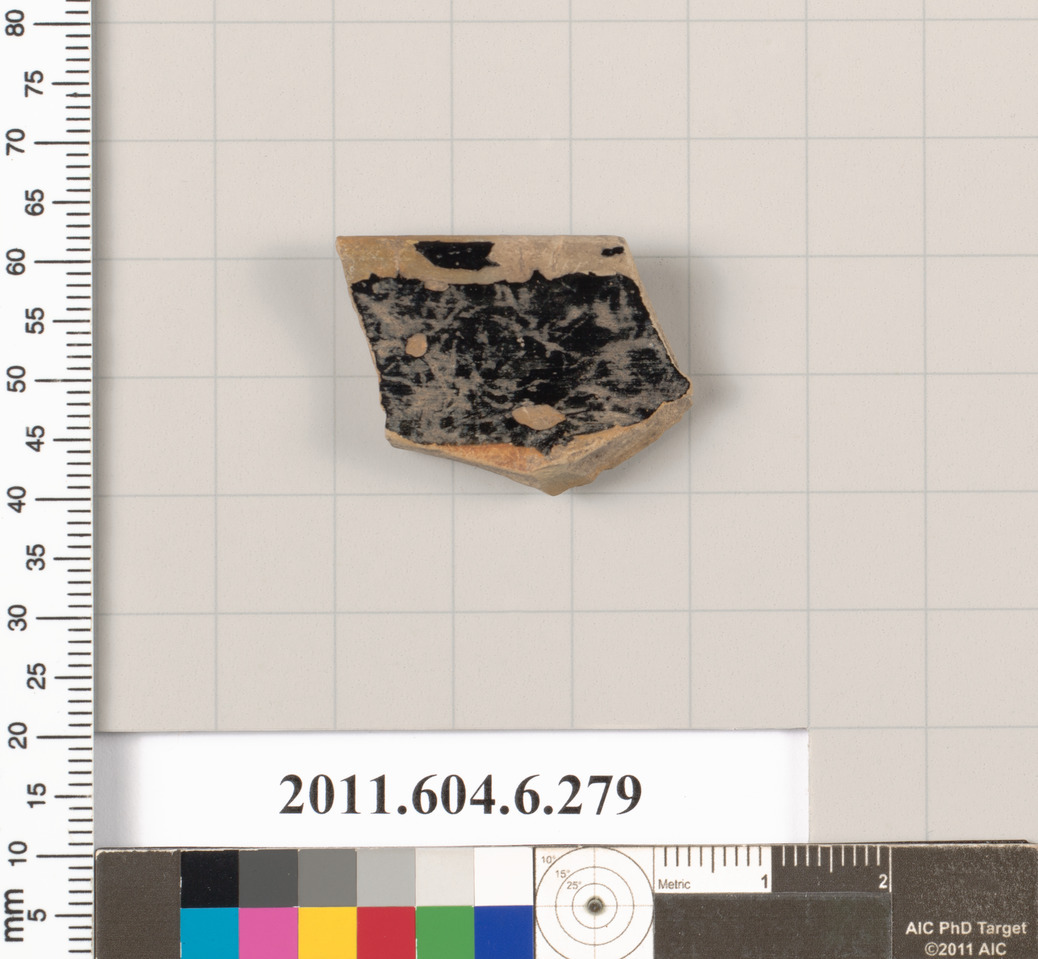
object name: undetermined open shape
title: Terracotta rim fragment of an open shape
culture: greek, attic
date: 500-401 BCE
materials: terracotta